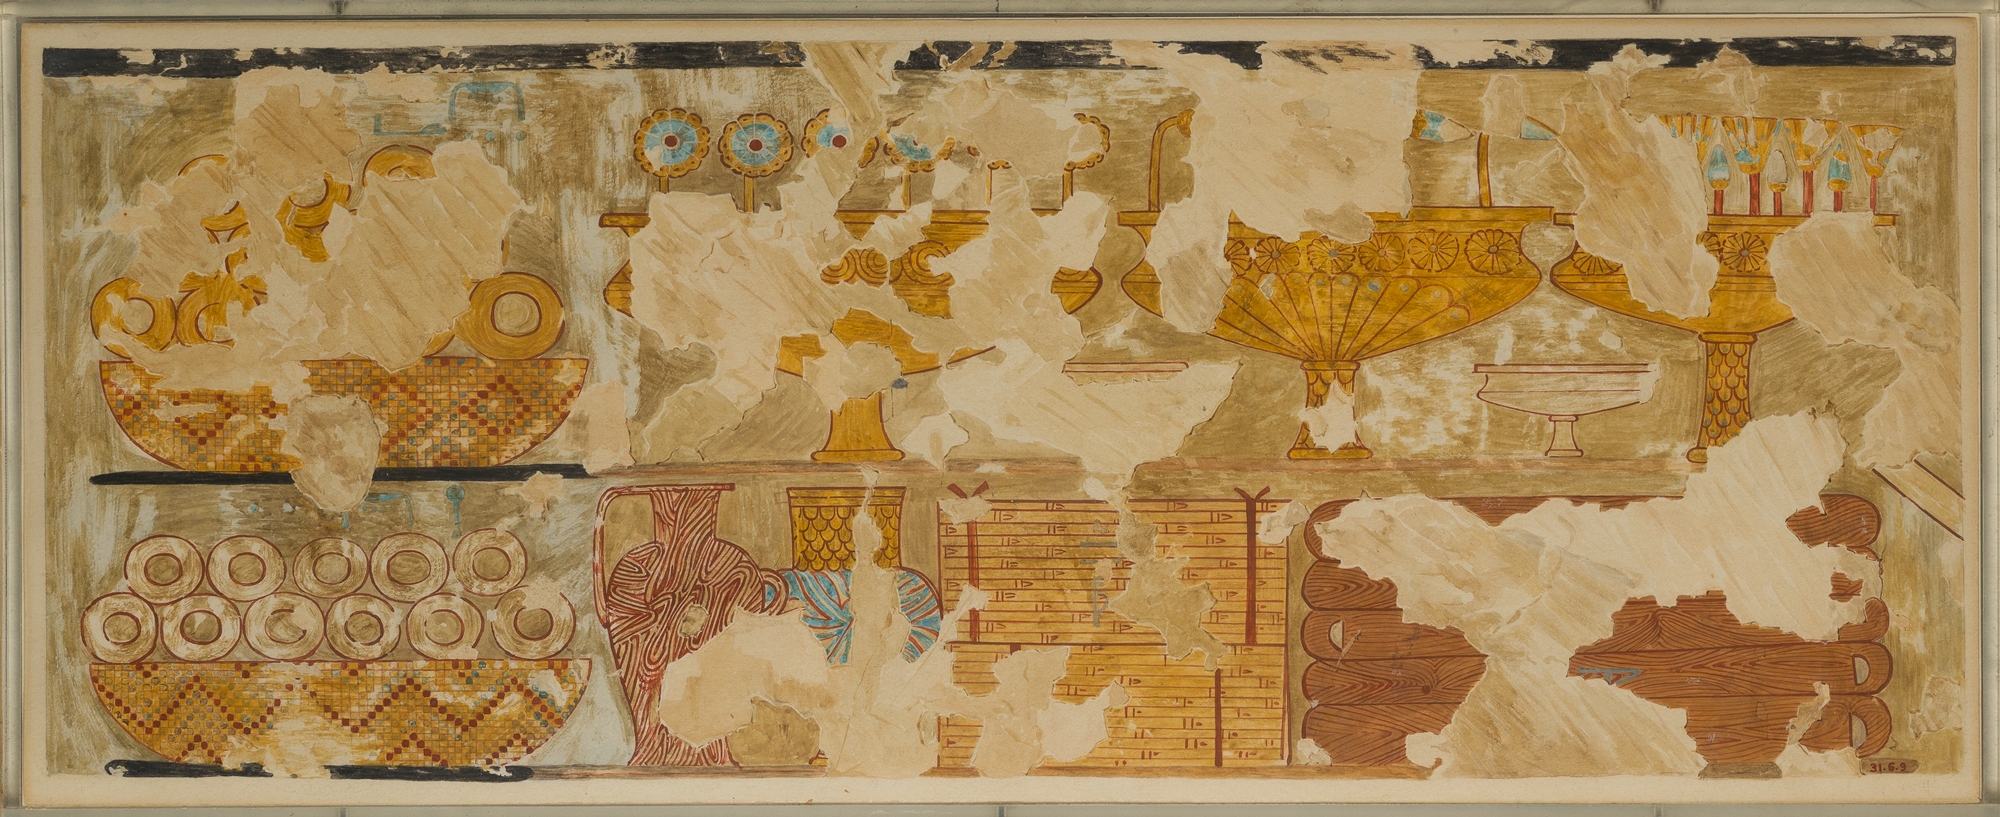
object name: facsimile, rekhmire tt 100, gift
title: Gifts from Western Asia, Tomb of Rekhmire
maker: nina de garis davies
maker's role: artist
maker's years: 1881-1965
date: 1504-1425 BCE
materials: ink, paint, paper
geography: egypt